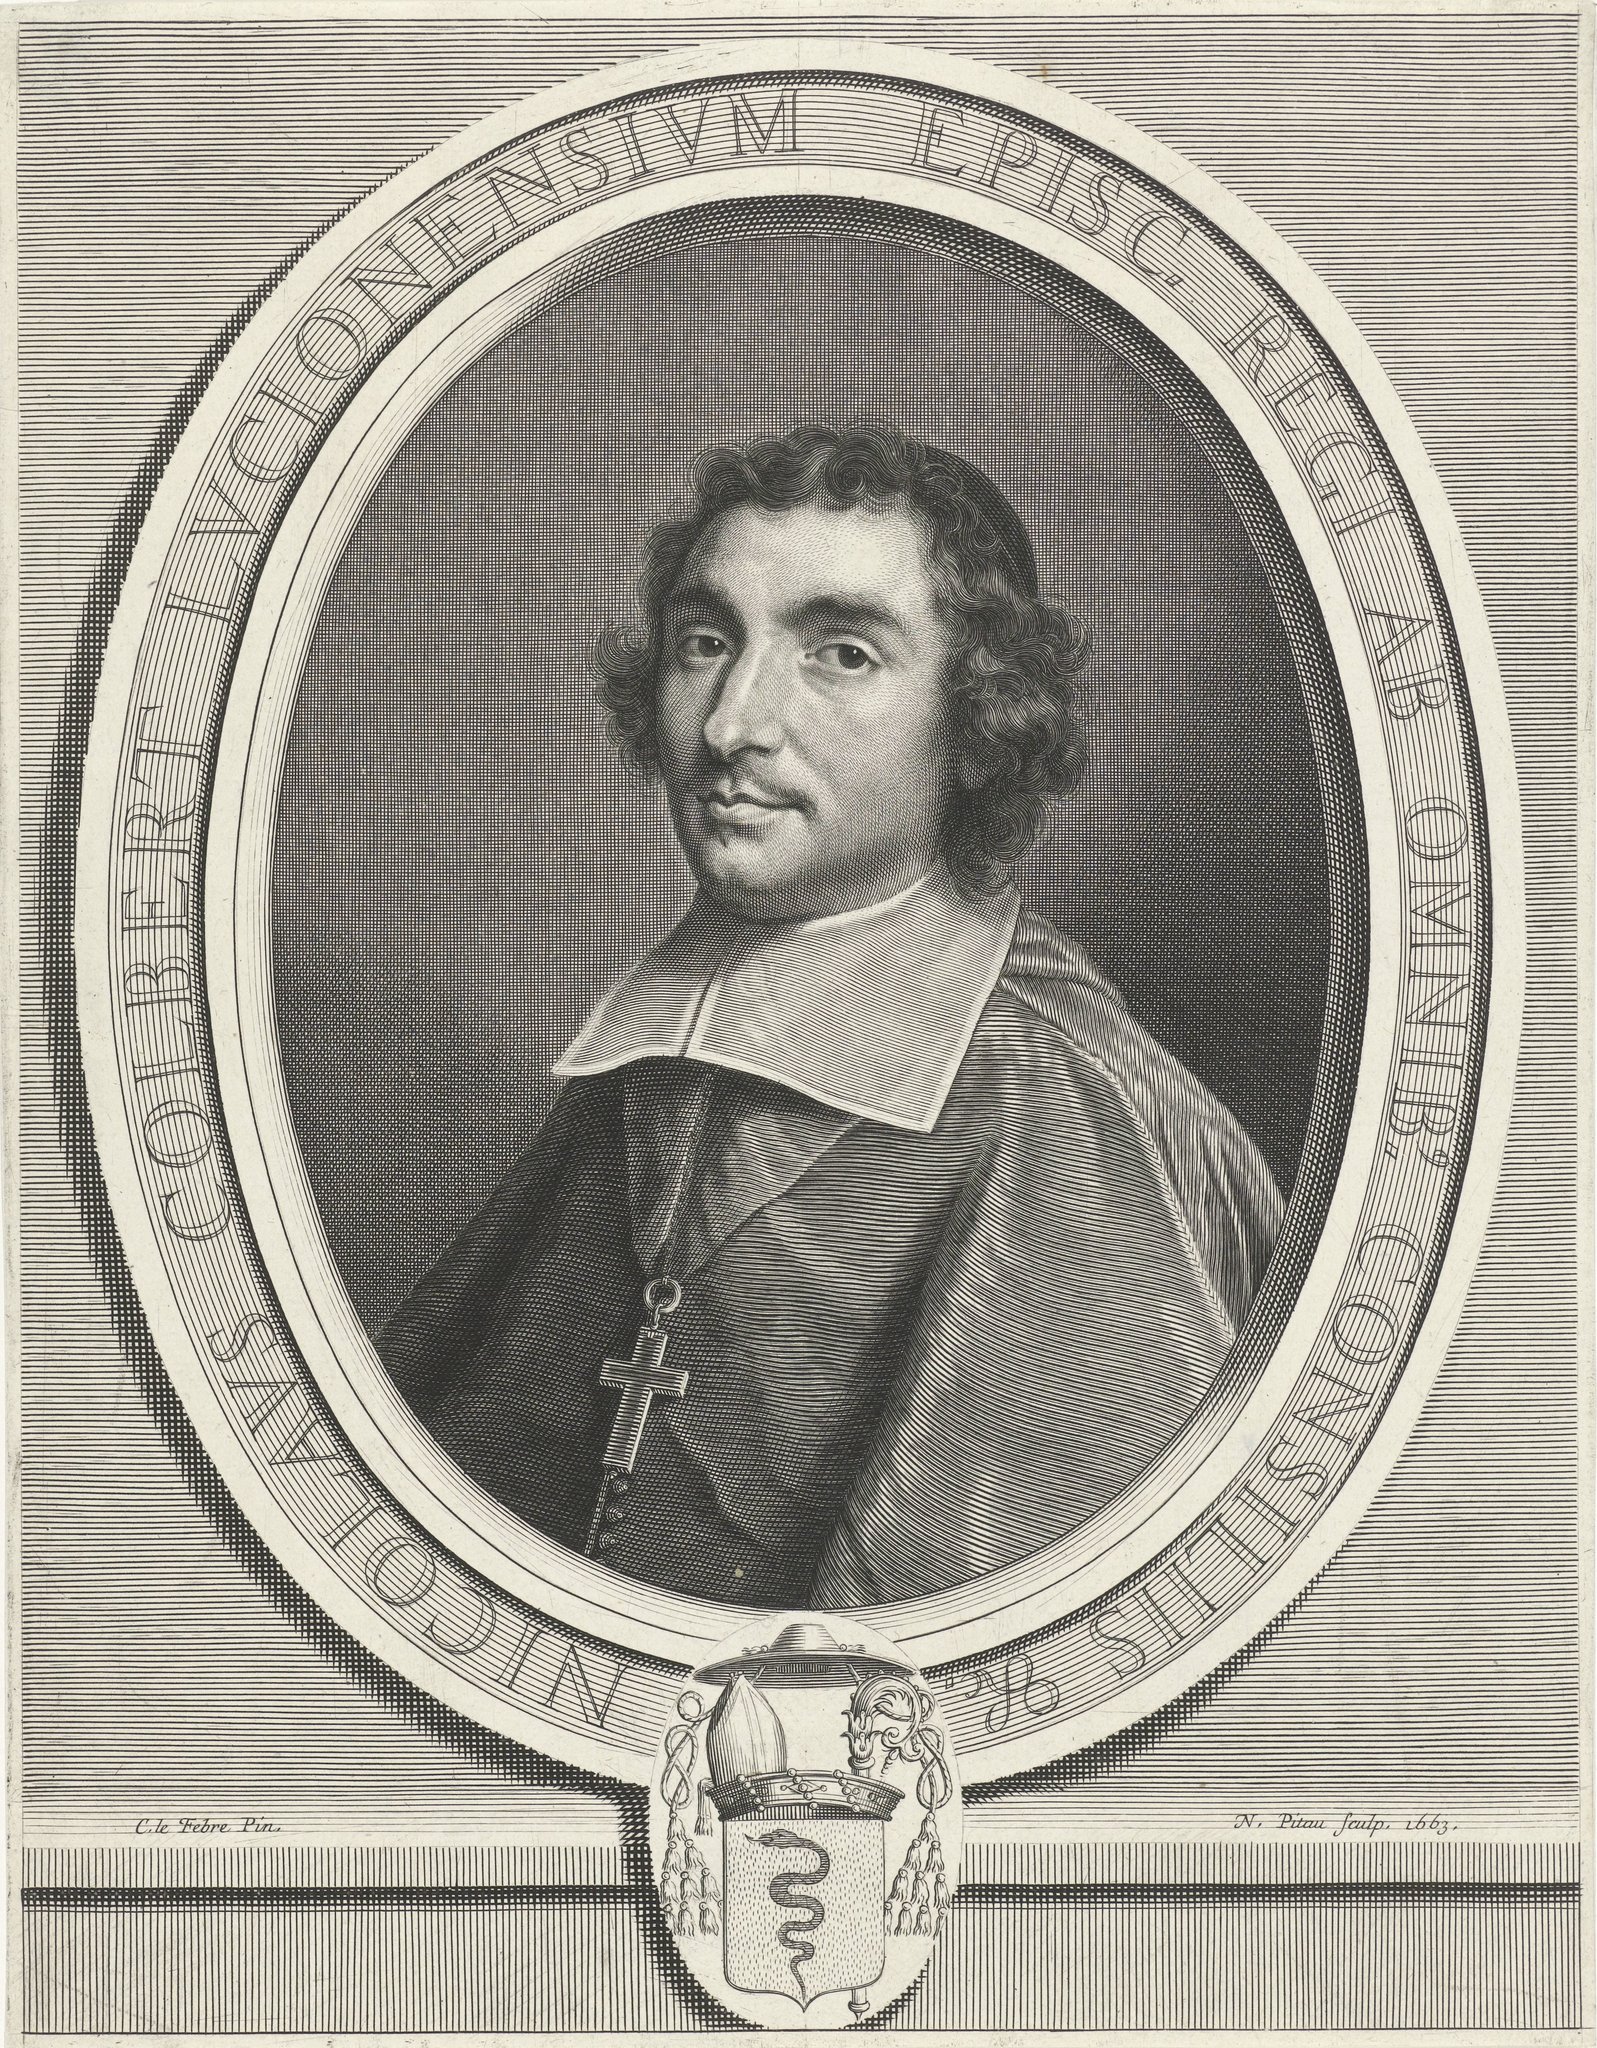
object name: print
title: Portret van Jacques-Nicolas Colbert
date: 1663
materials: paper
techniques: engraving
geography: paris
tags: paris, jacques-nicolas colbert, archbishop, bishop, etc. (roman catholic), armorial bearing, heraldry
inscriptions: collector's mark: Lugt 2228